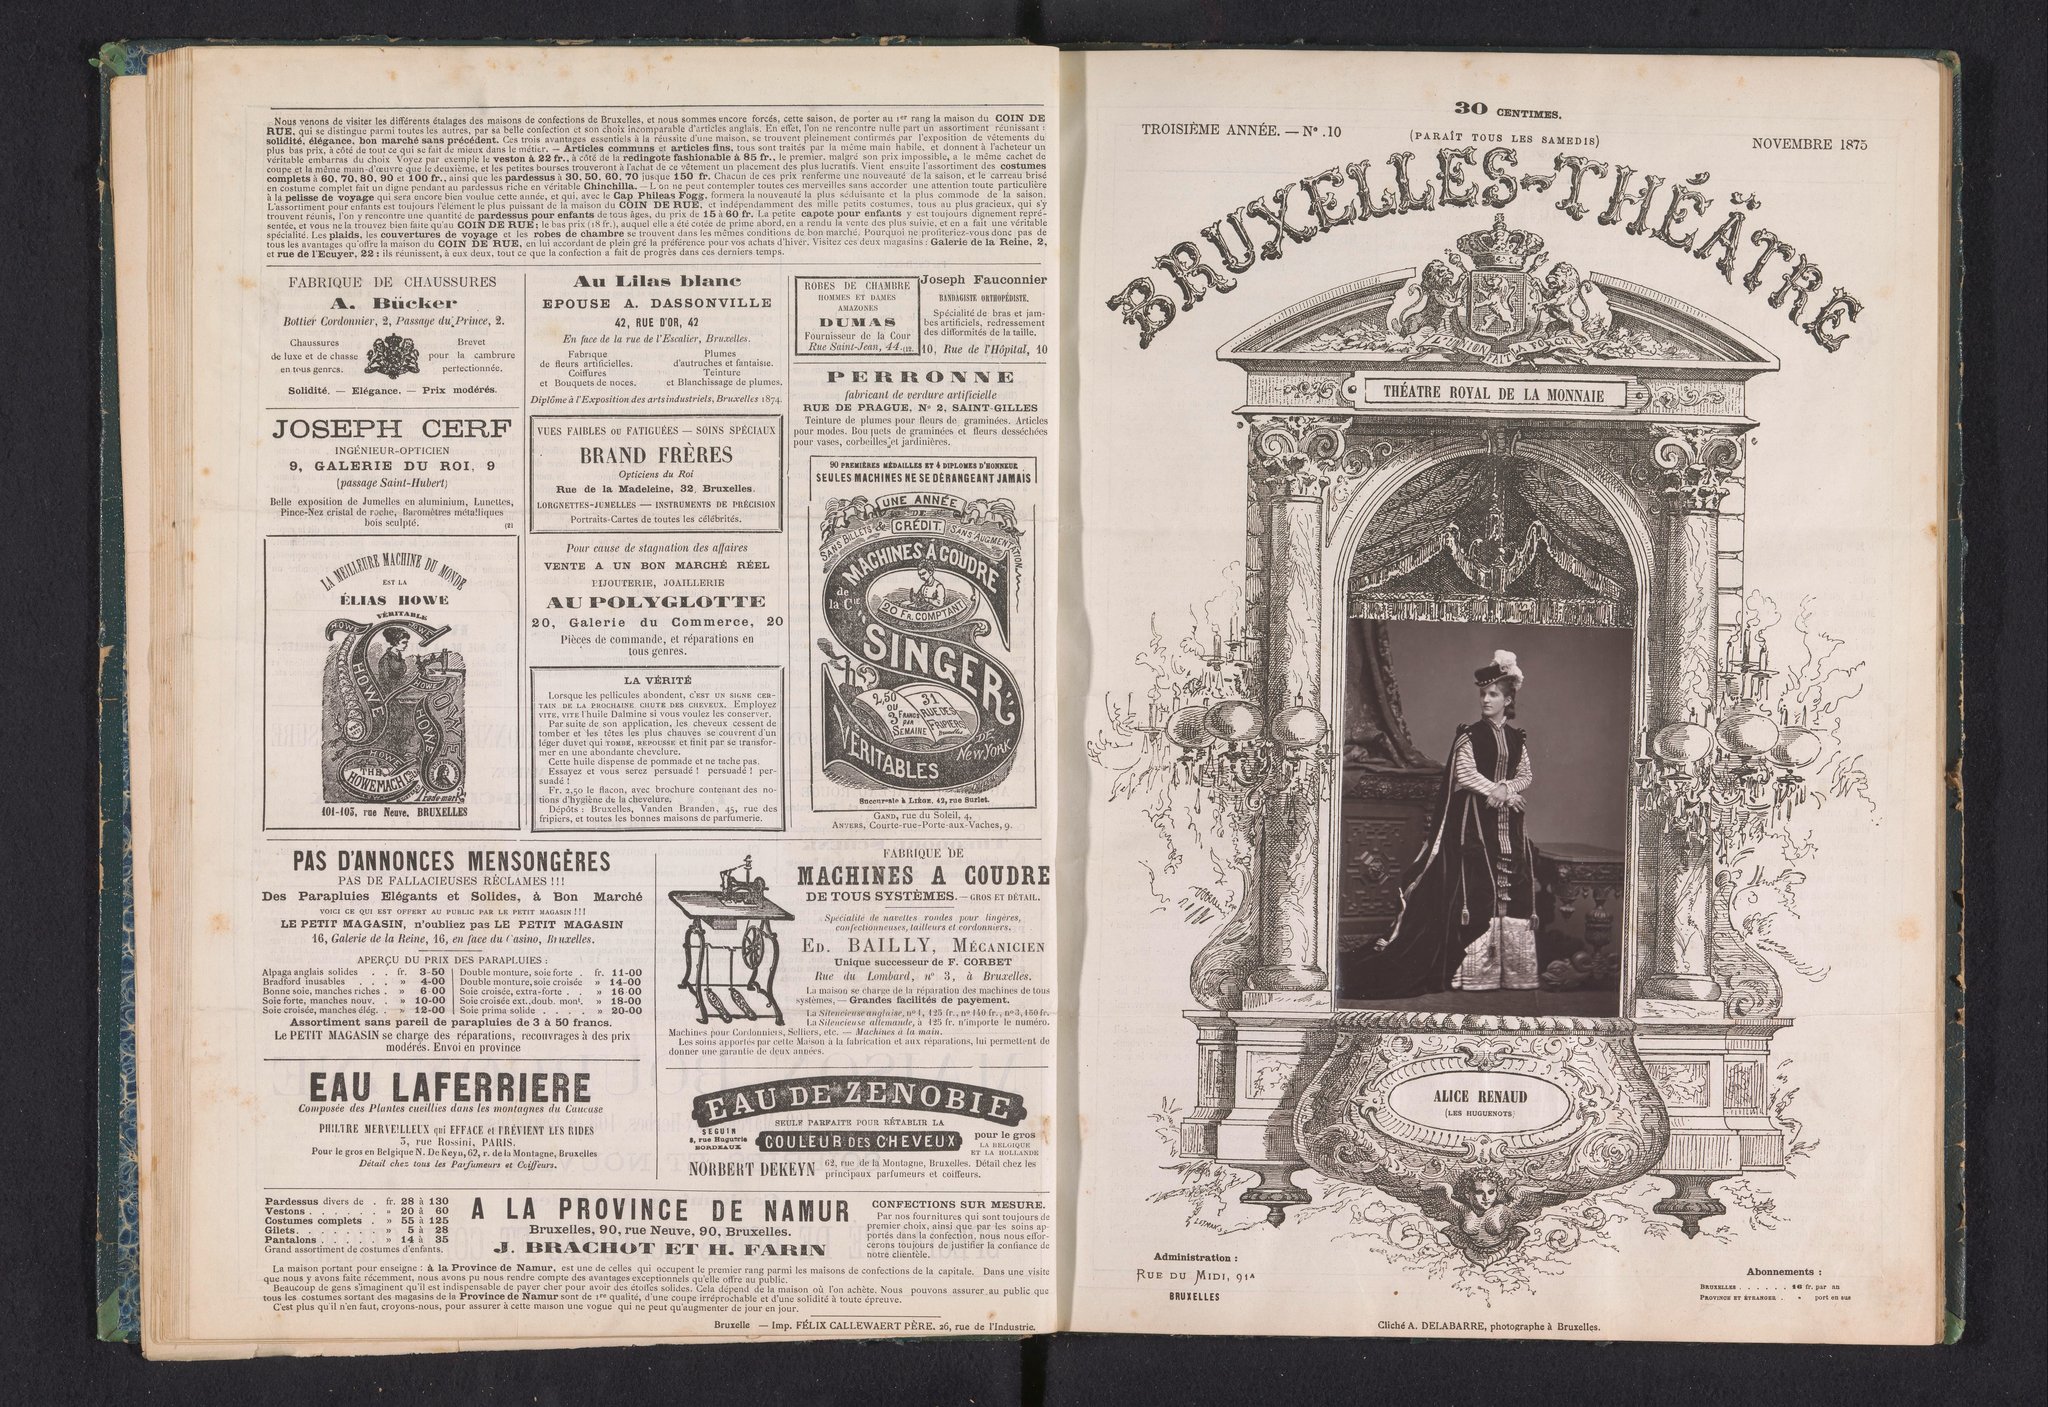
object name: photomechanical print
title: Portret van Alice Renaud in Les huguenots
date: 1870-1875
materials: paper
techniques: woodburytype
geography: brussels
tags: portrait of actor, actress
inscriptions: number: ‘No 10.’